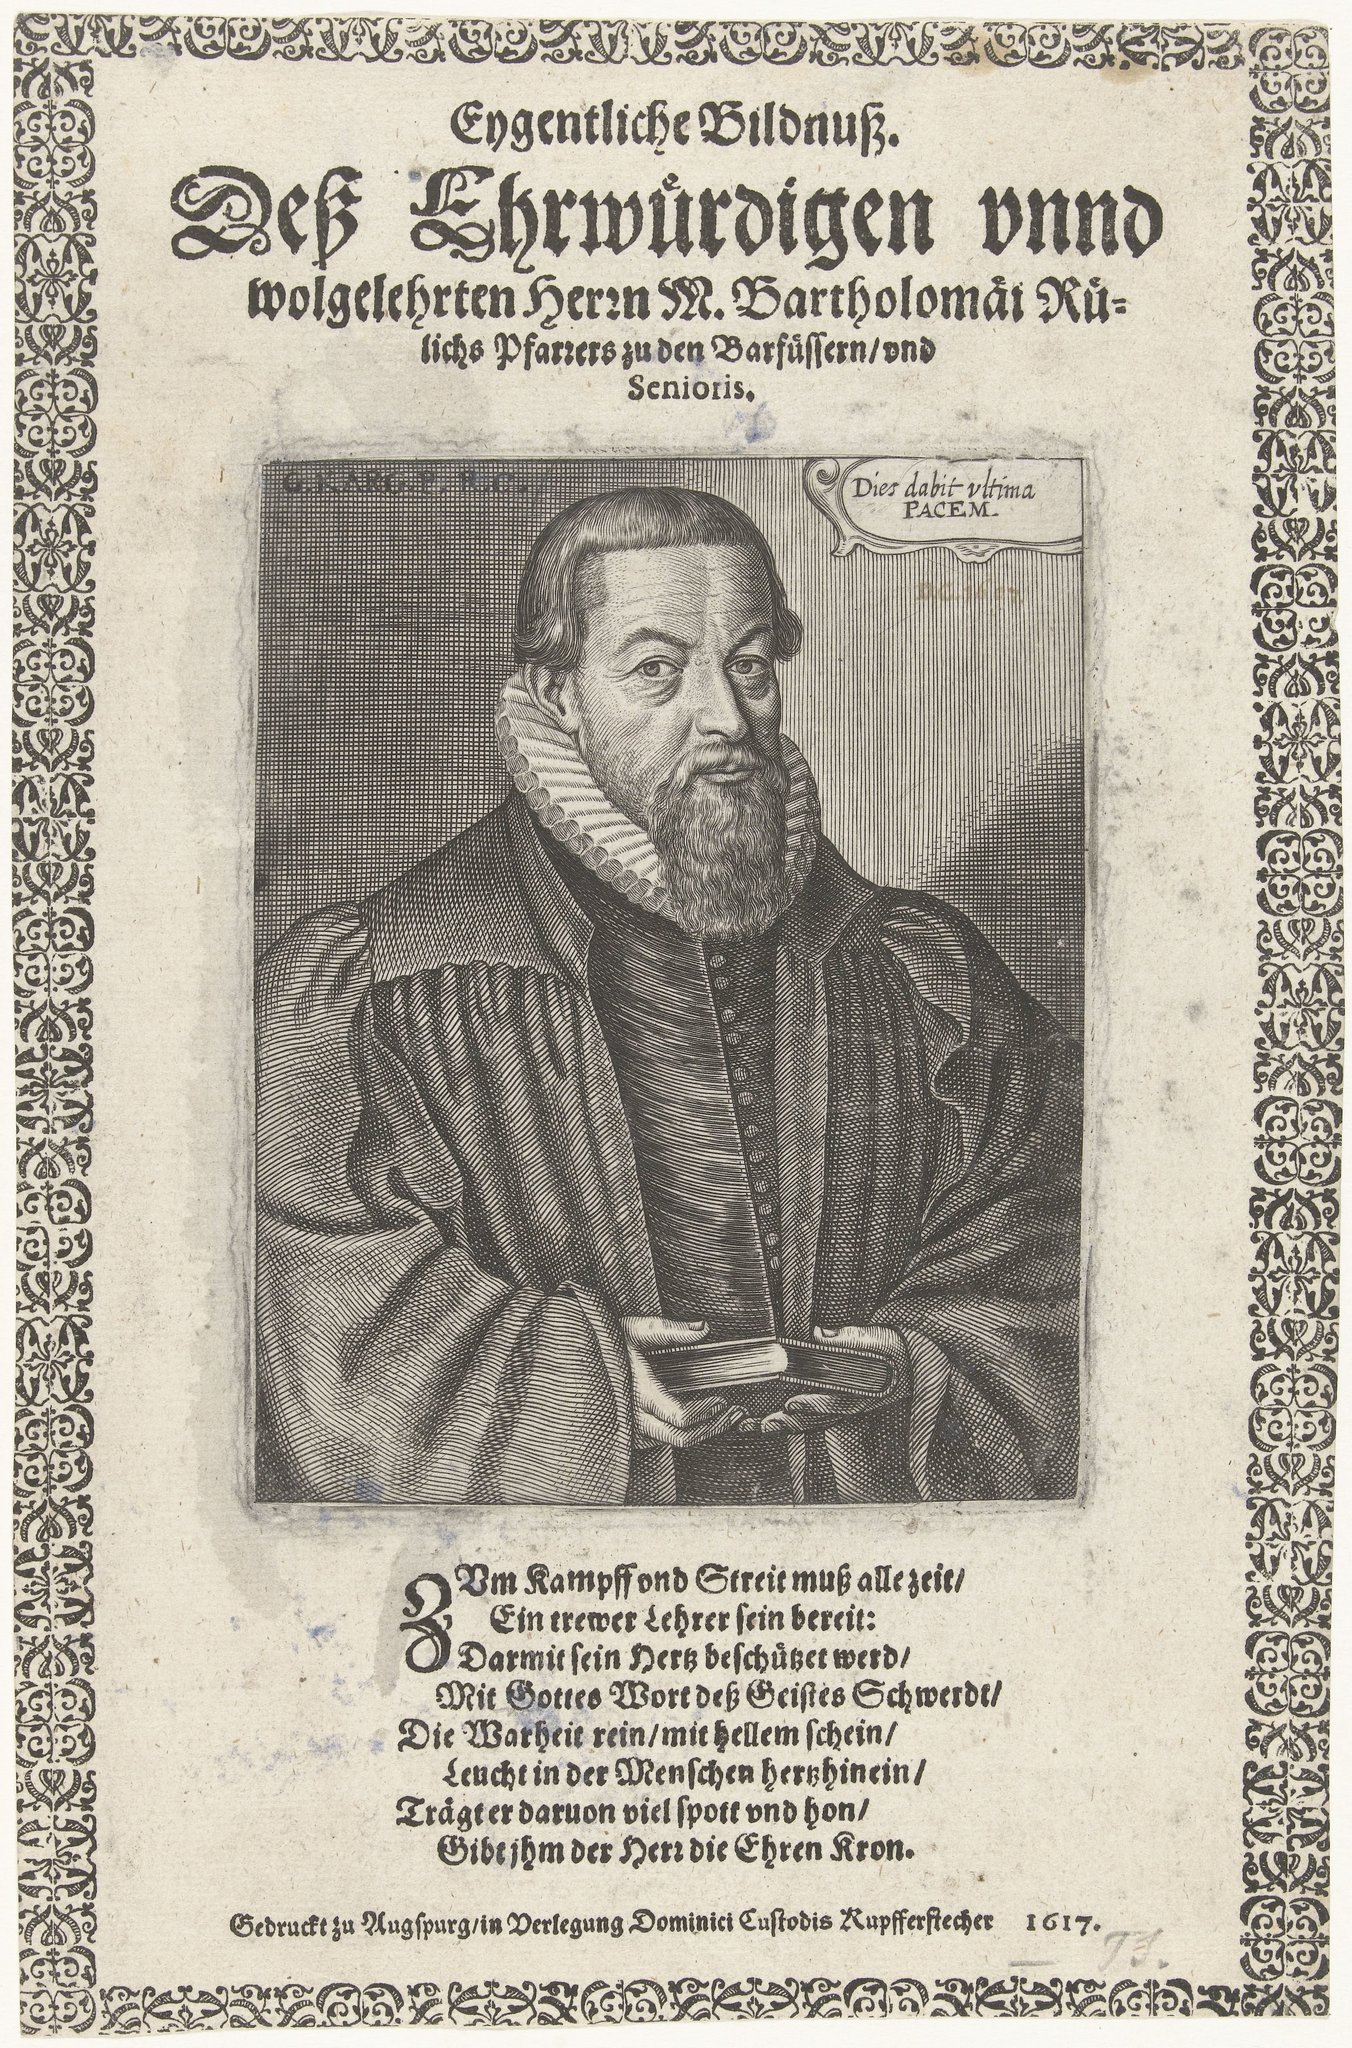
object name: print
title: Portret van dominee Bartholomaeus Rülichs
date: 1617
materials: paper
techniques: engraving, letterpress printing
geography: augsburg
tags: dominee, bartholomaeus rülichs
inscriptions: collector's mark: Lugt 2228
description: Portret van dominee Bartholomaeus Rülichs met boek in zijn handen. Rechts boven een motto: Dies dabit ultima pacem. Onder het portret een Duits vers over de strijdvaardigheid van de geestelijke.